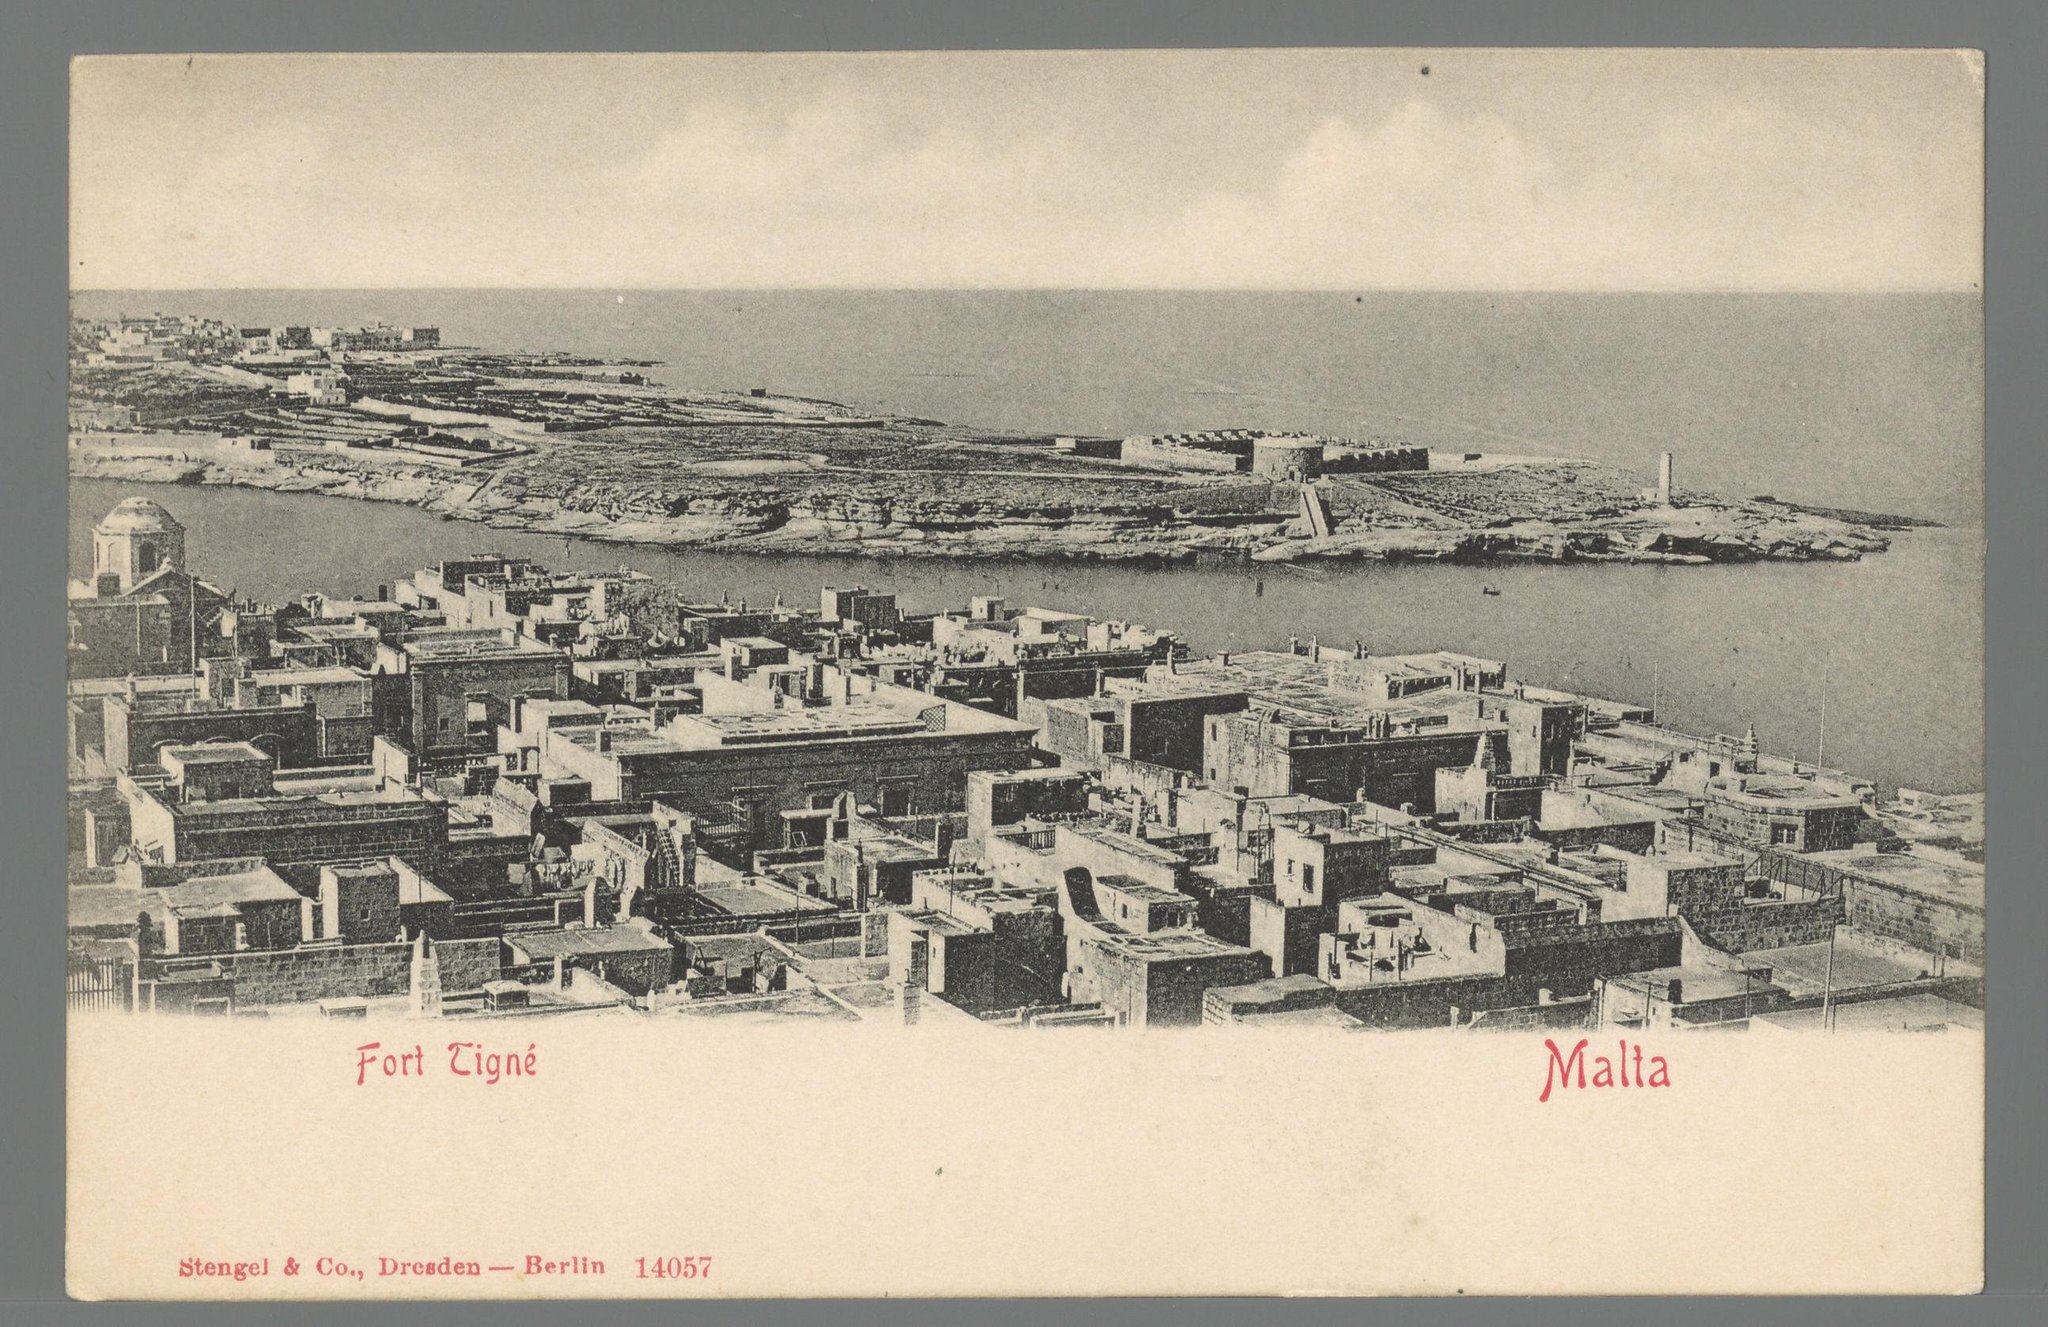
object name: photomechanical print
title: Fort Tigné. Malta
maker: Anonymous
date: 1890-1906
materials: cardboard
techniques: photograph, writing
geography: malta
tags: fortress, city-view, and landscape with man-made constructions, sea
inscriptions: poststempel, verso, gestempeld